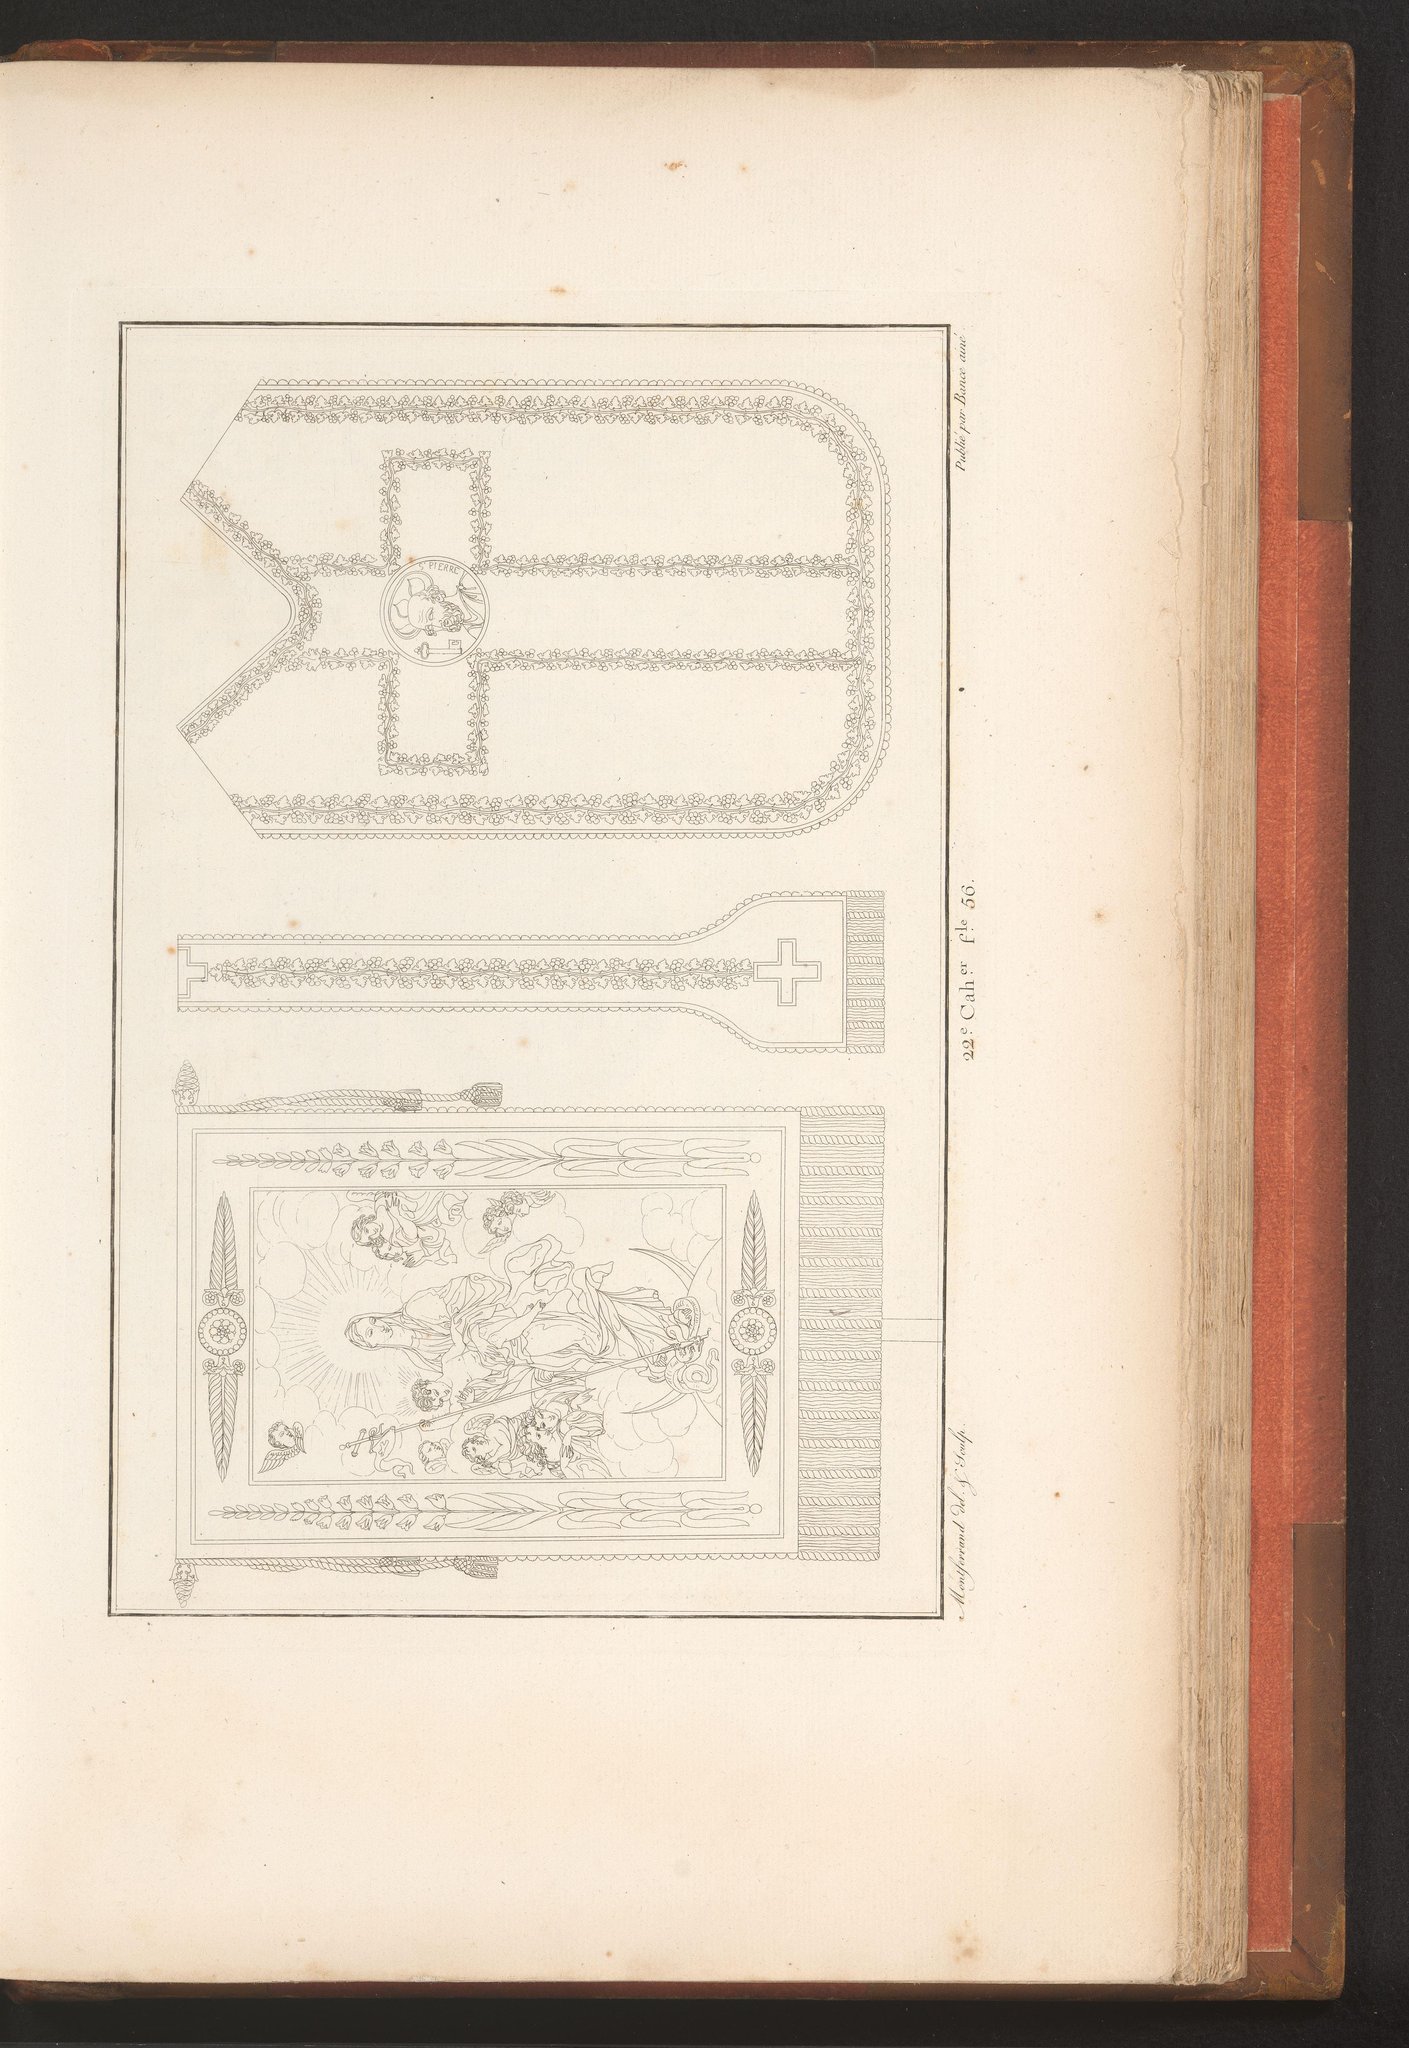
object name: ornament print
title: Wandkleed en kazuifel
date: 1820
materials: paper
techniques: etching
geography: paris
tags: ornaments ~ art, chasuble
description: Wandkleed en kazuifel. Onderdeel (22e. Cah.er f.le 56) van het prentalbum met twee series van in totaal 138 ornamentprenten door Beauvallet en Normand, 'Fragmens d'Ornemens dans le Style Antique'.